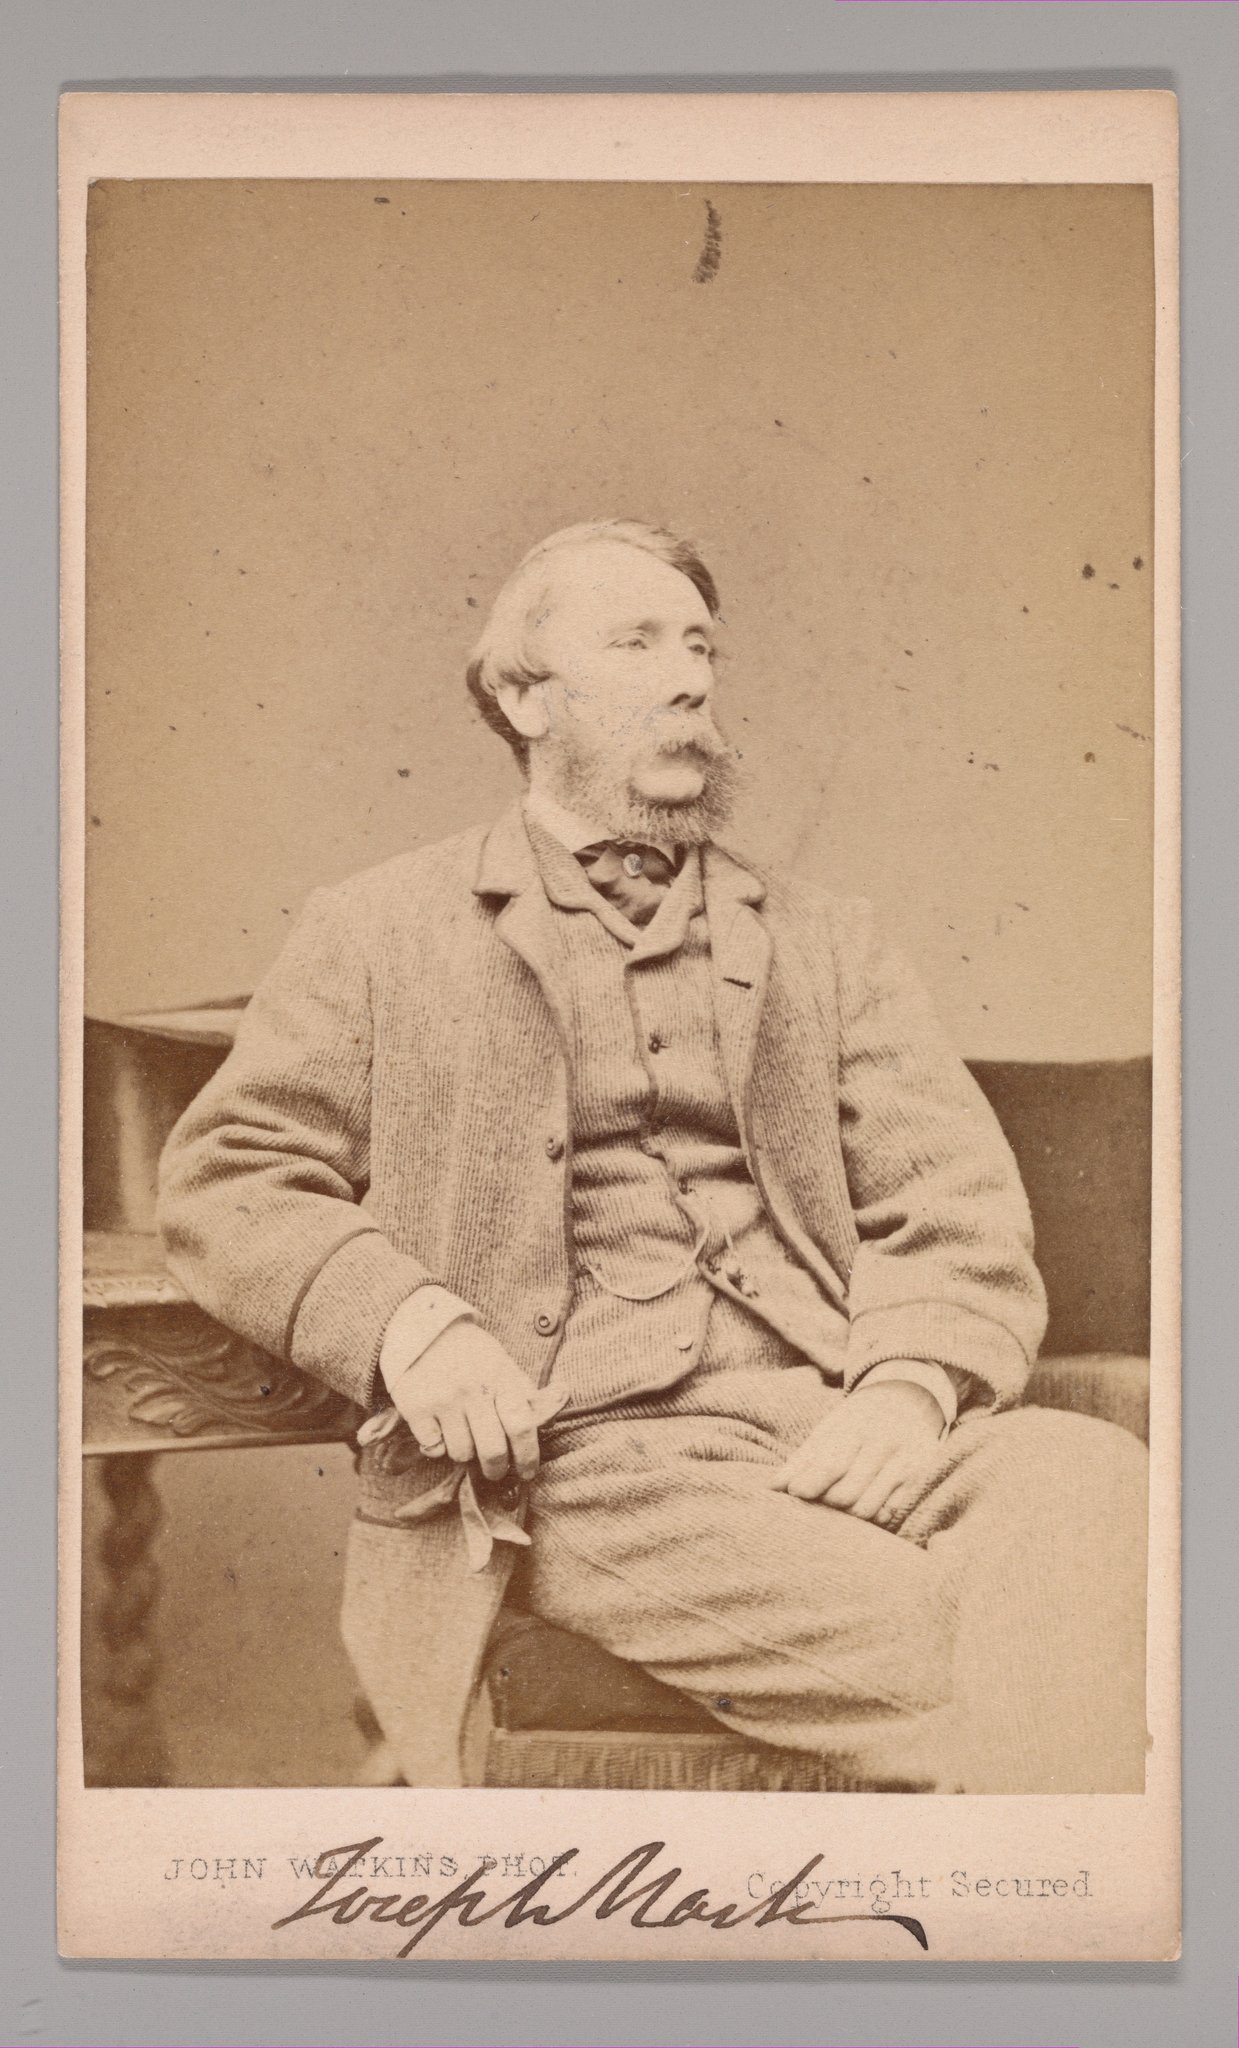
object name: carte de visite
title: [Joseph Nash]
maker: john and charles watkins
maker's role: photography studio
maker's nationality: british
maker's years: 1840-1875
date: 1860-1869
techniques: albumen silver print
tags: men,portraits